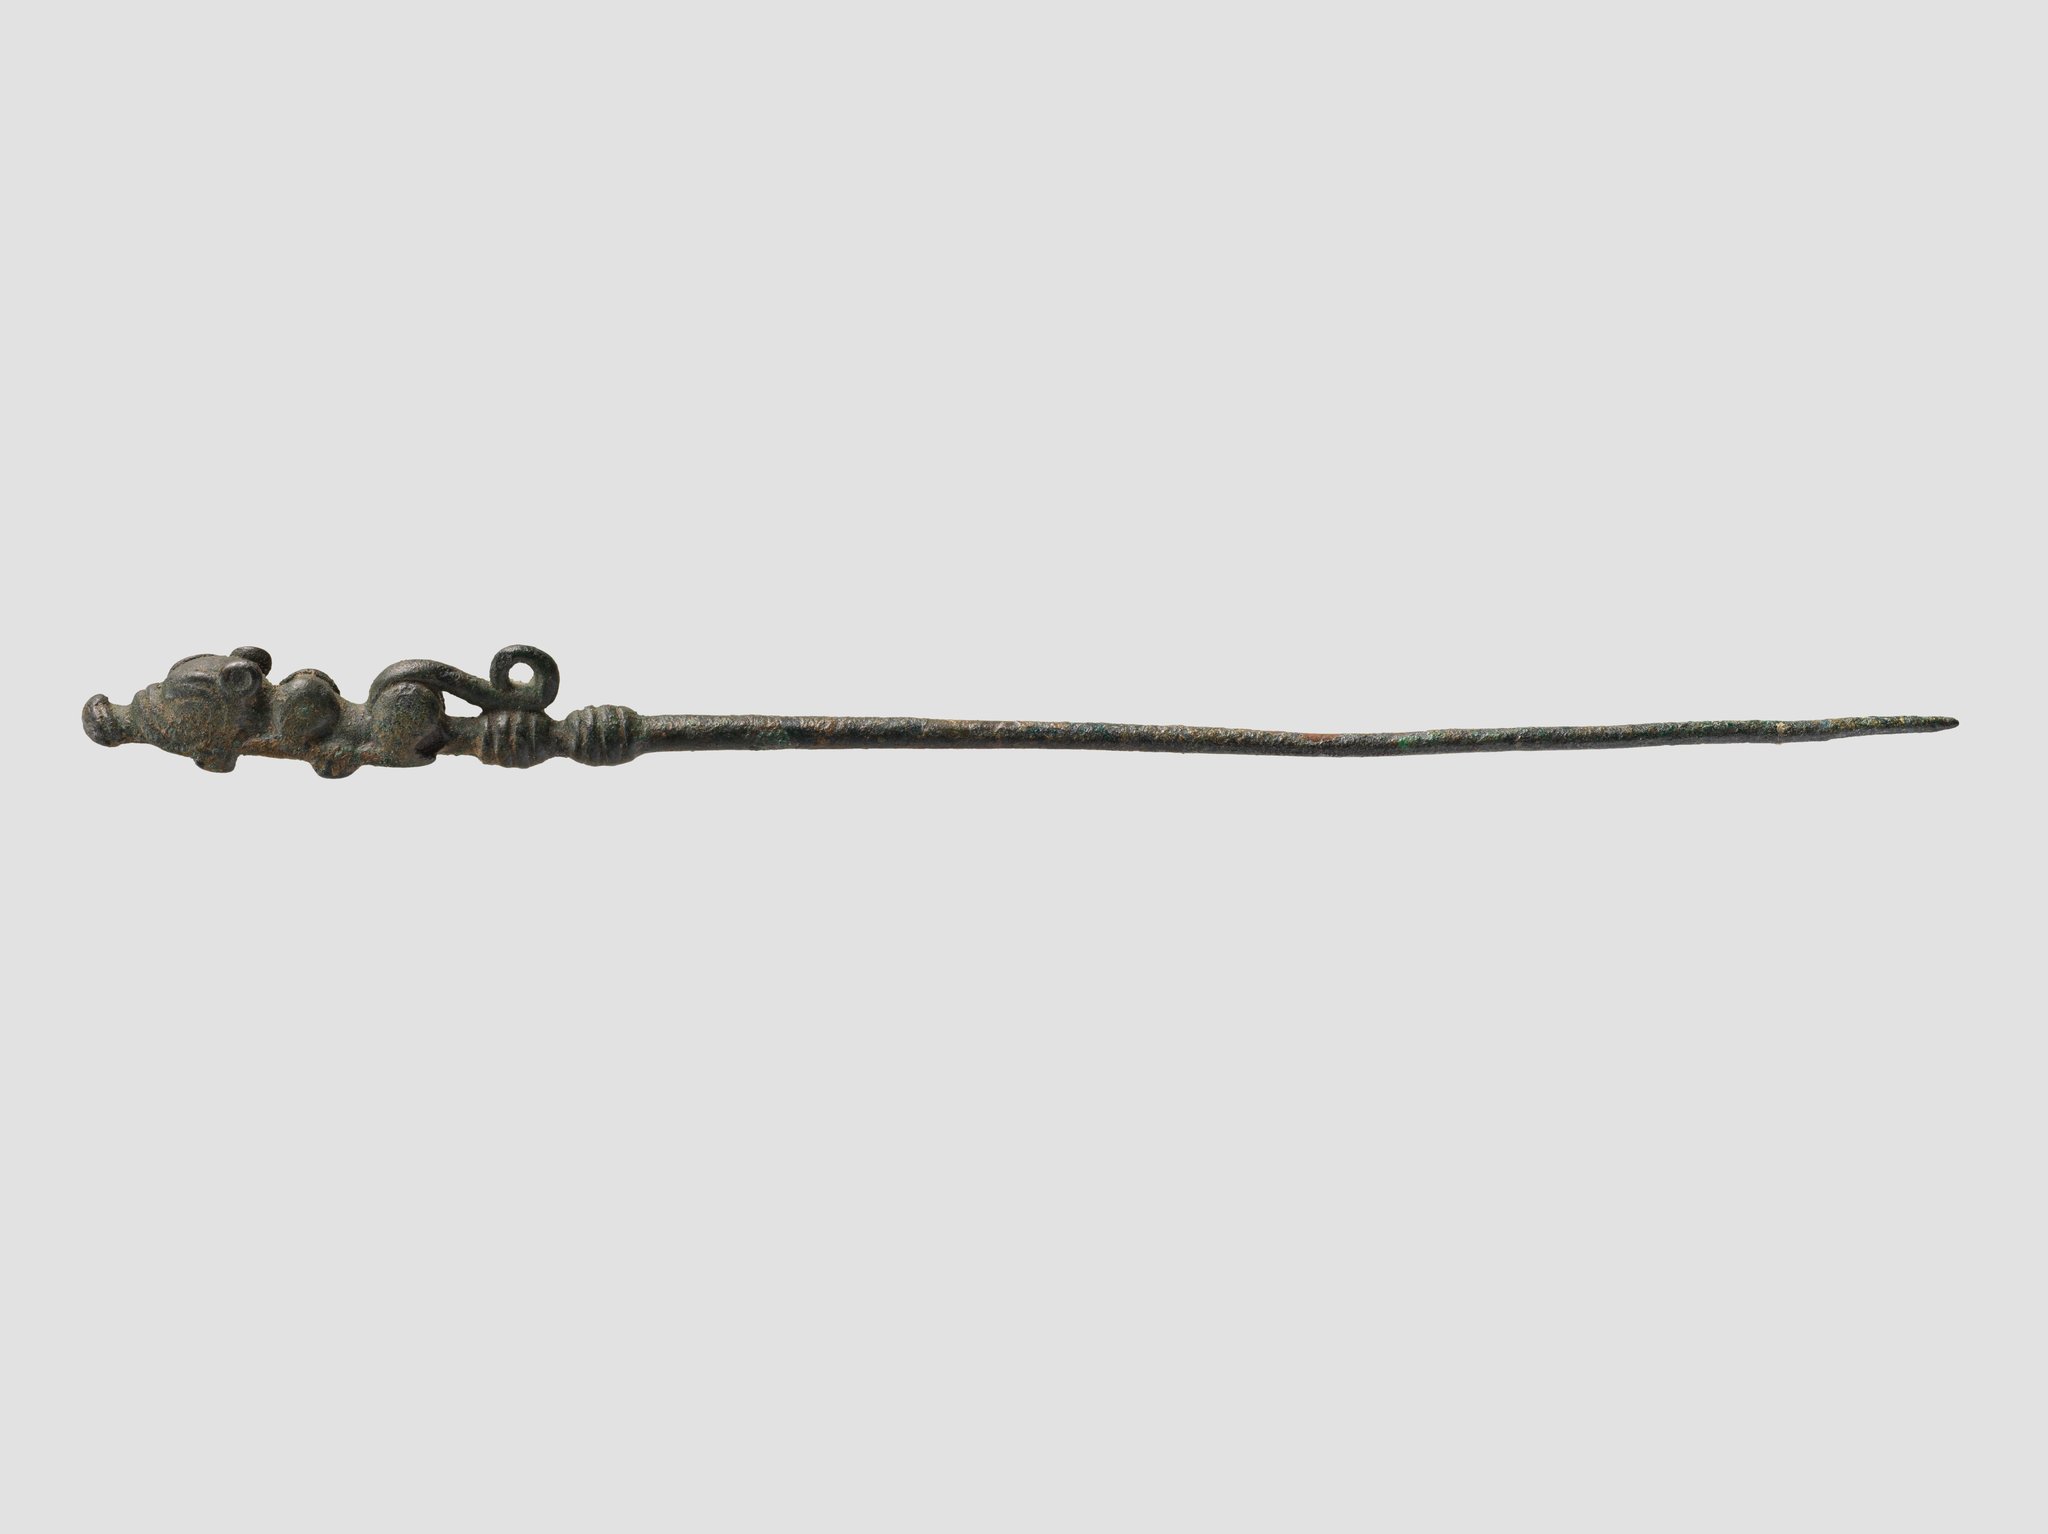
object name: pin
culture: iranian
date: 800-601 BCE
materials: bronze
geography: iran, probably from luristan